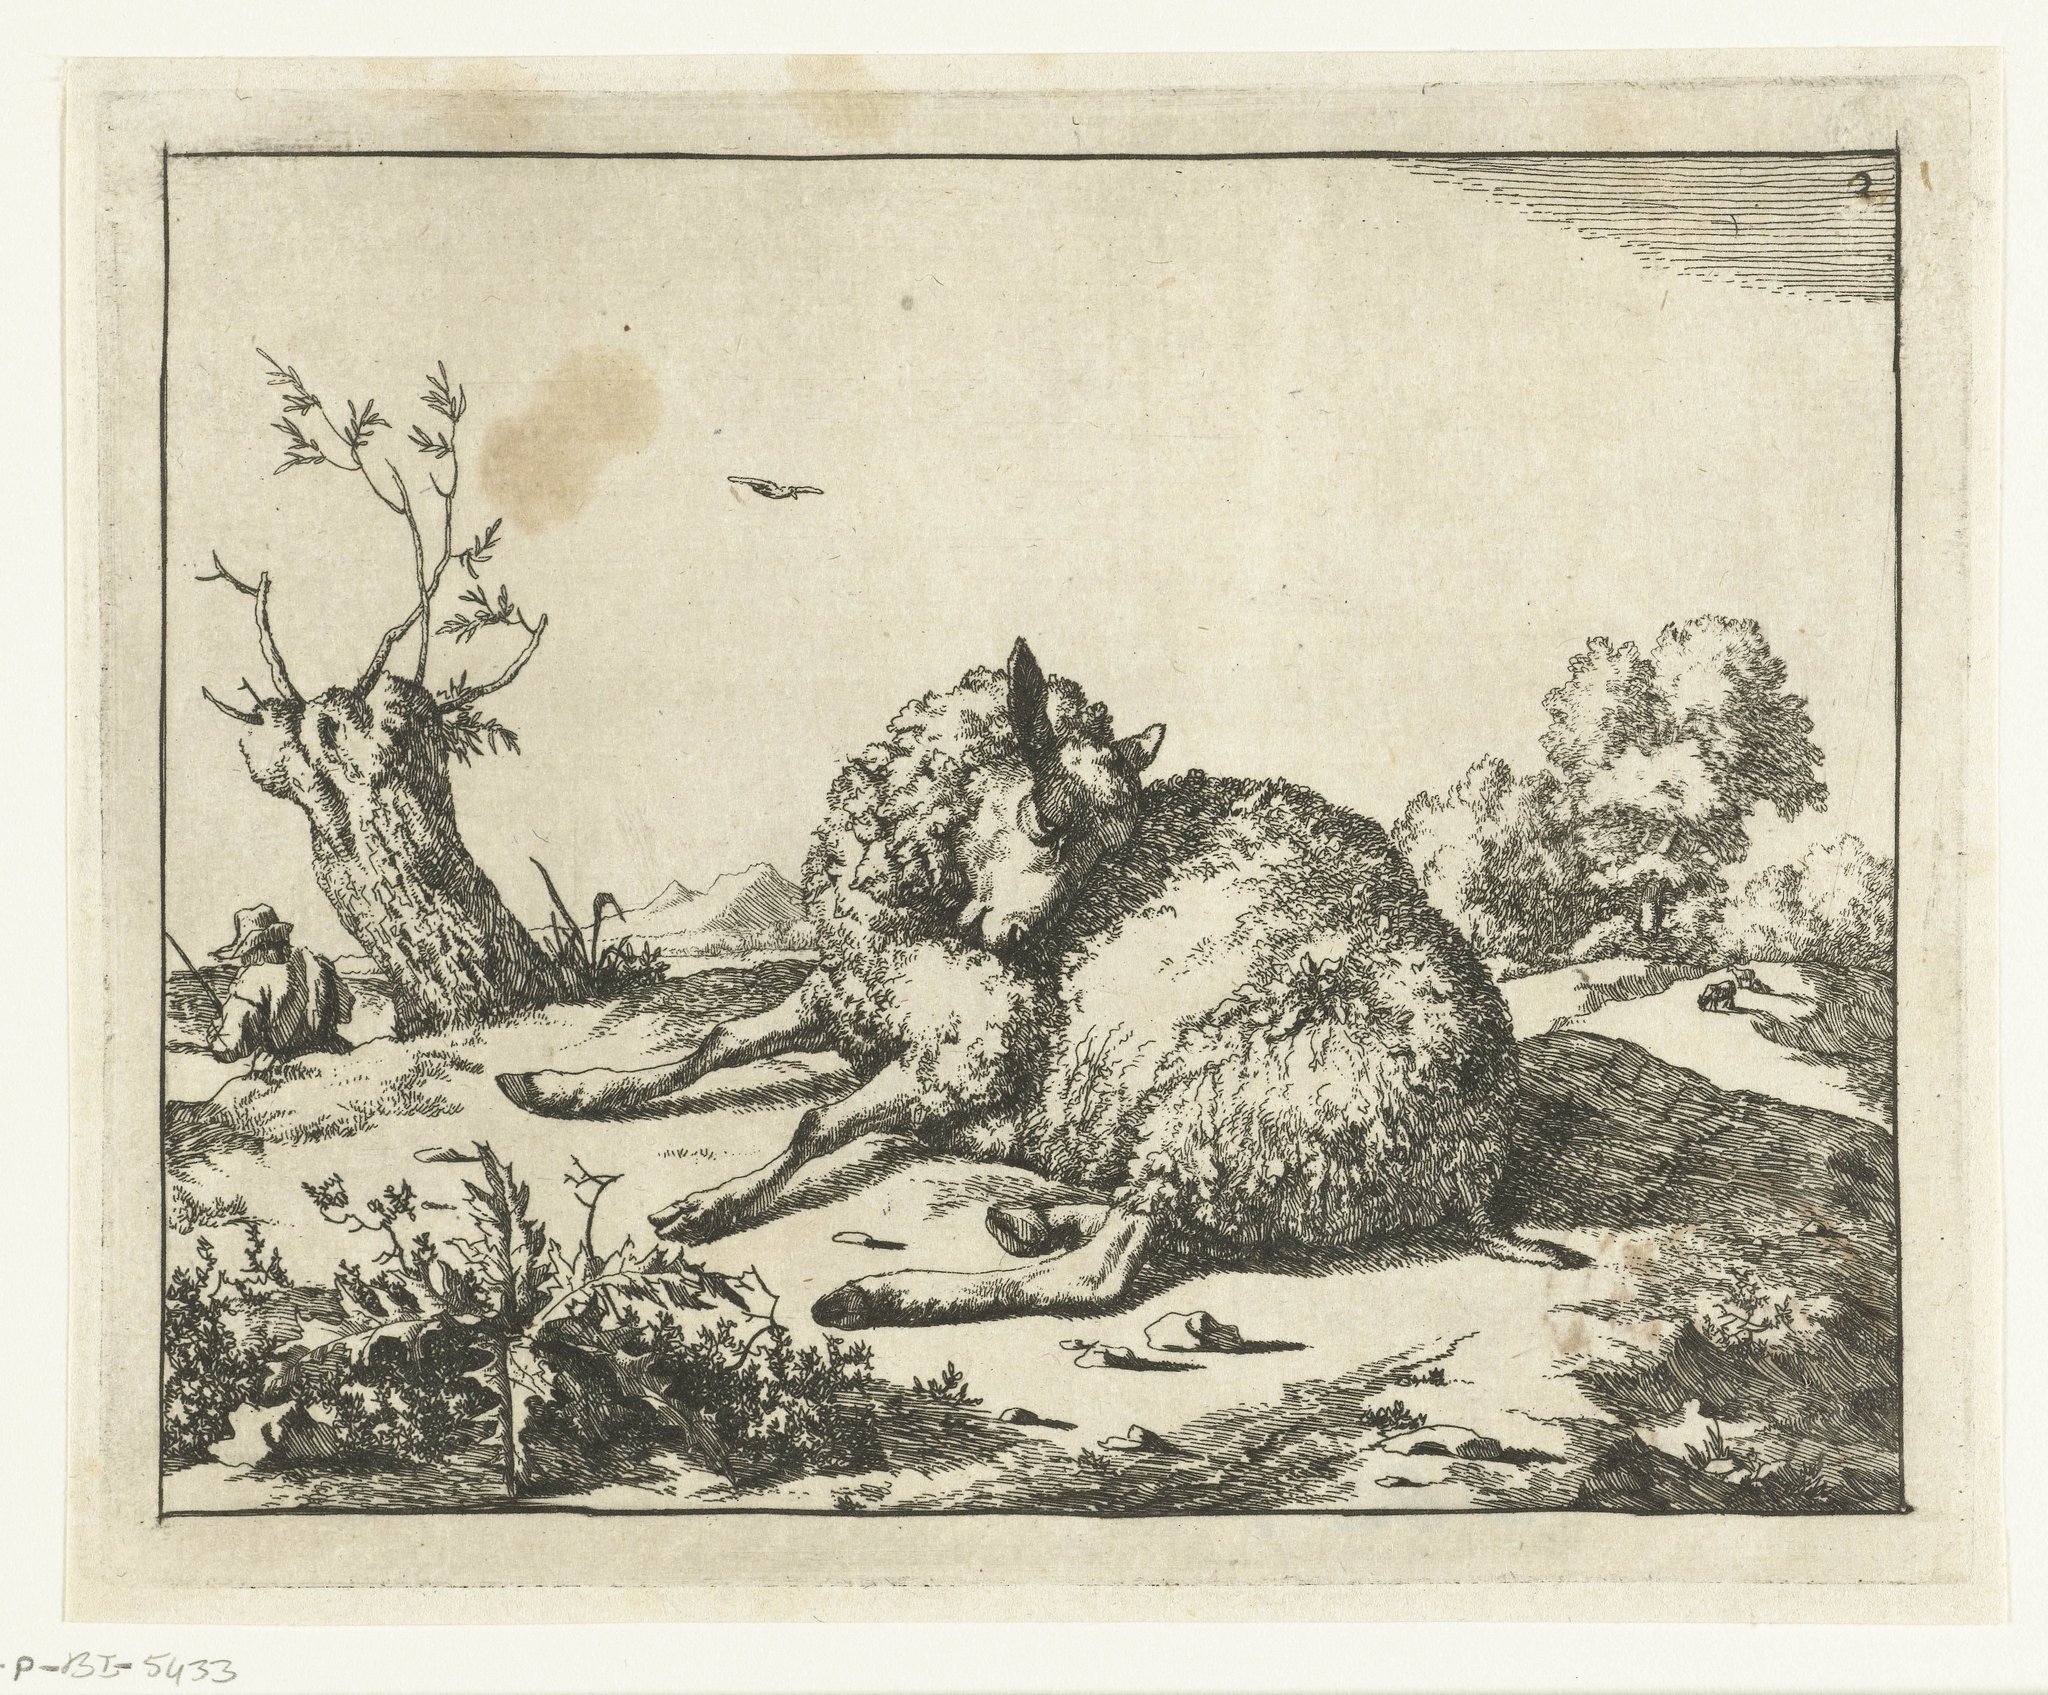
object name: print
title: Schapen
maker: marcus de bye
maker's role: print maker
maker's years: 1639-1688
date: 1660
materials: paper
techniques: etching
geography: the hague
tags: sheep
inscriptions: collector's mark: Lugt 240